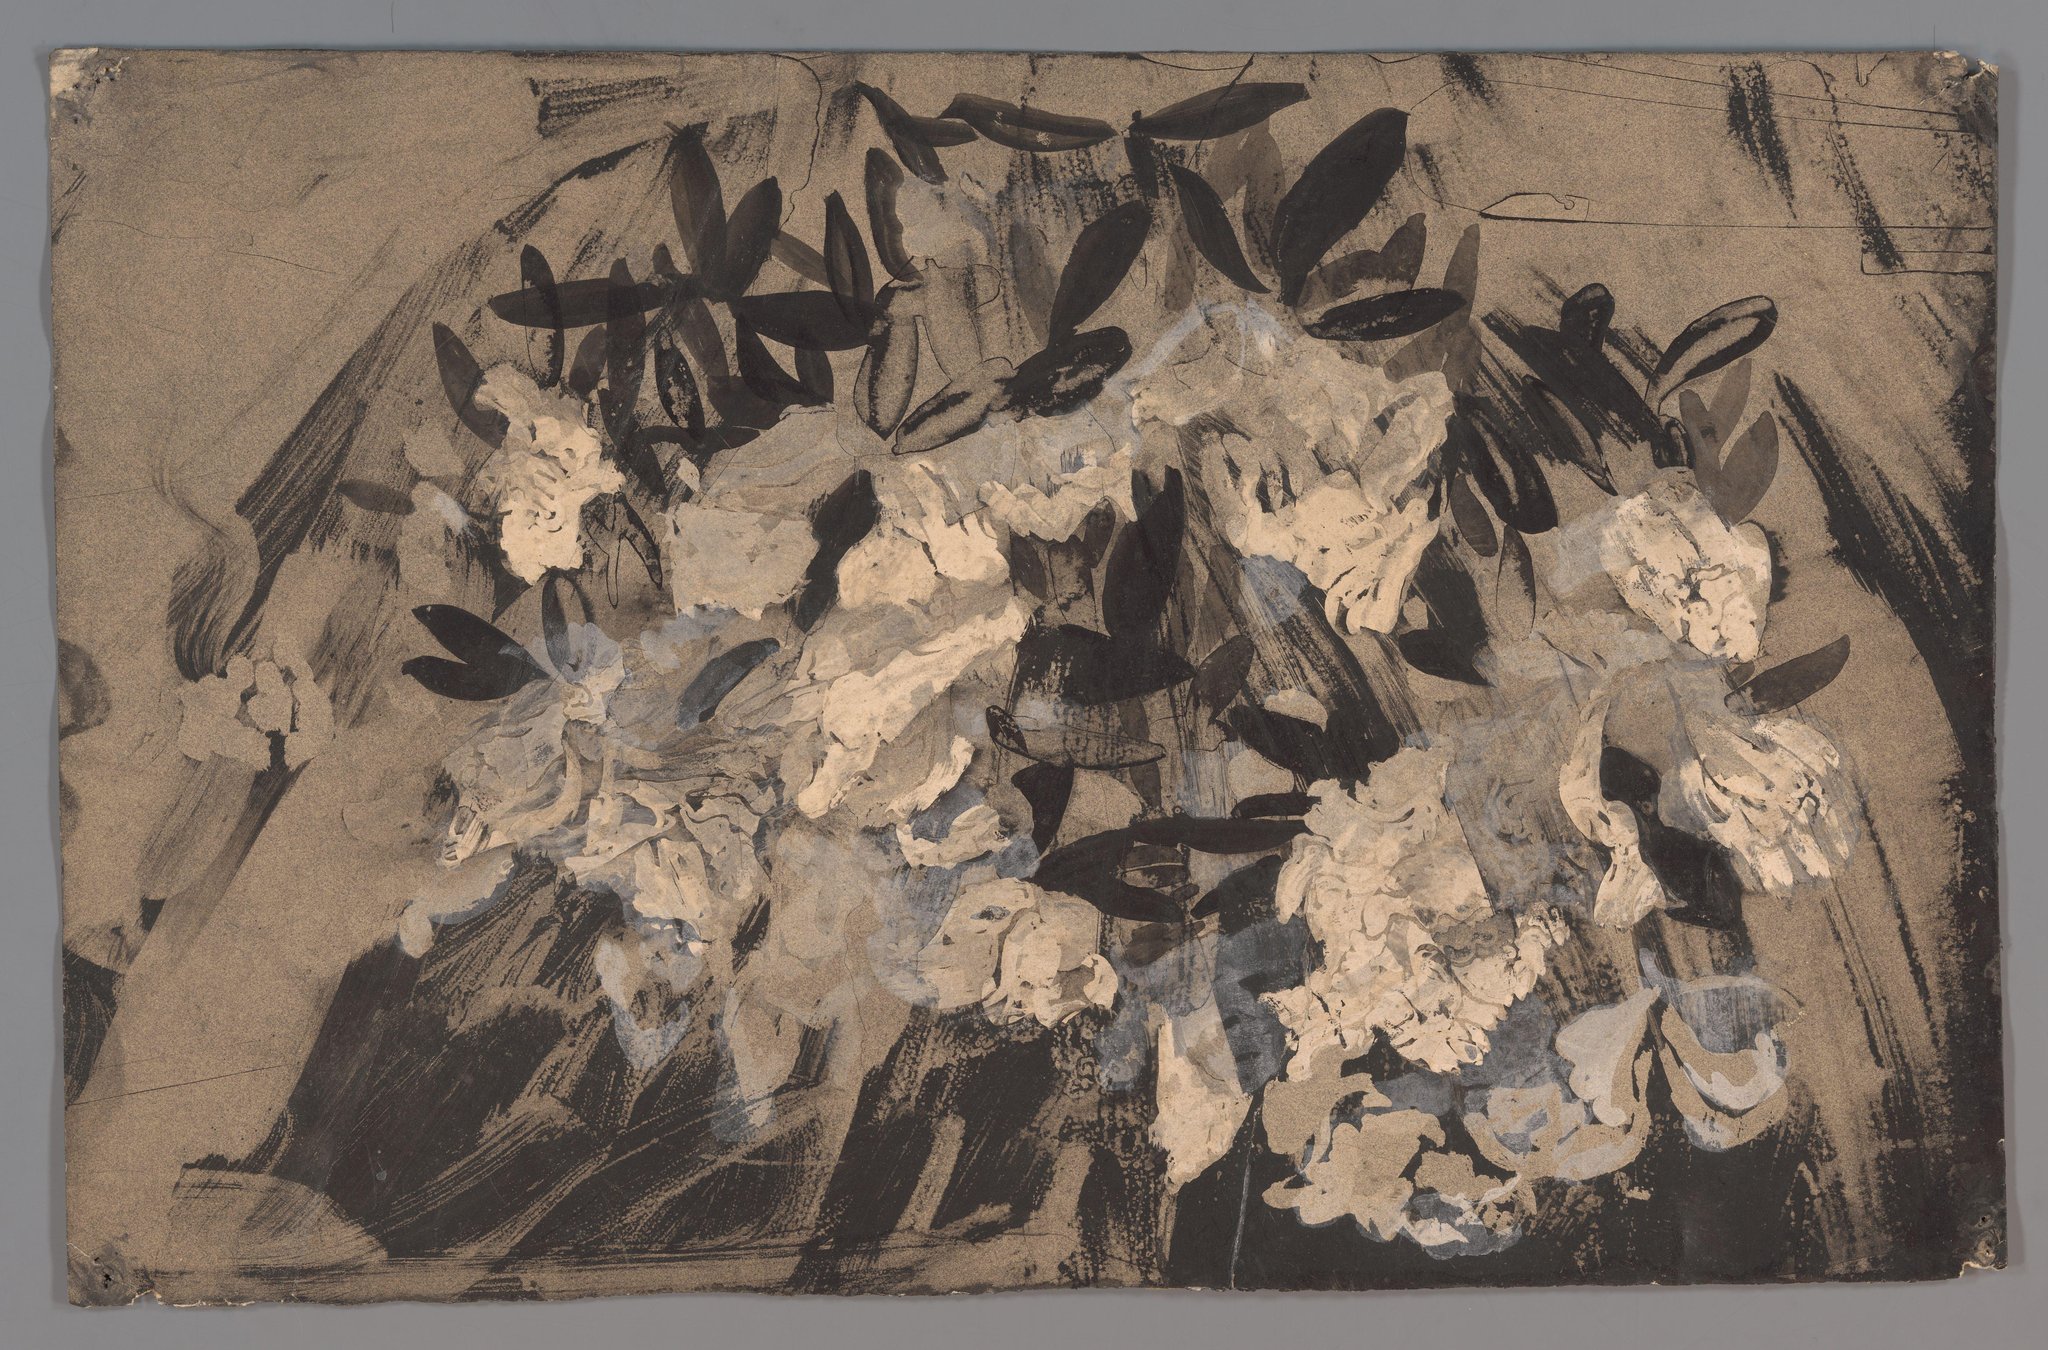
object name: drawing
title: Boeket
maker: carel adolph lion cachet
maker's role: draughtsman, print maker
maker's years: 1864-1945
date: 1874-1945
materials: paper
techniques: brush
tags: cut flowers; nosegay, bunch of flowers